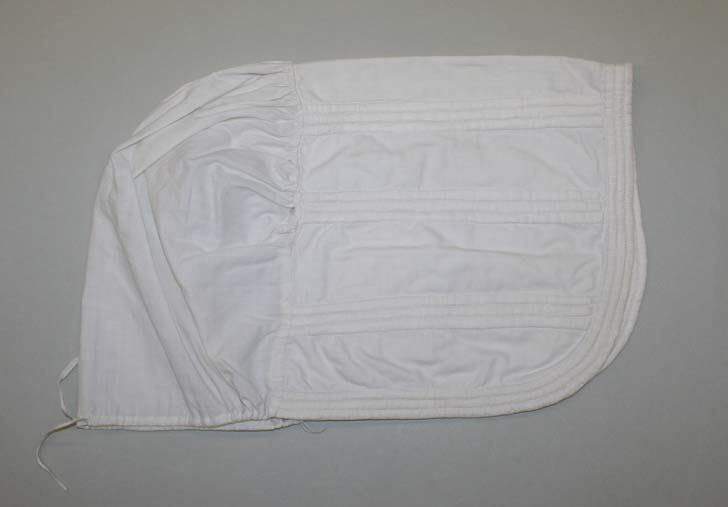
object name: bonnet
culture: american or european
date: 1810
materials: cotton